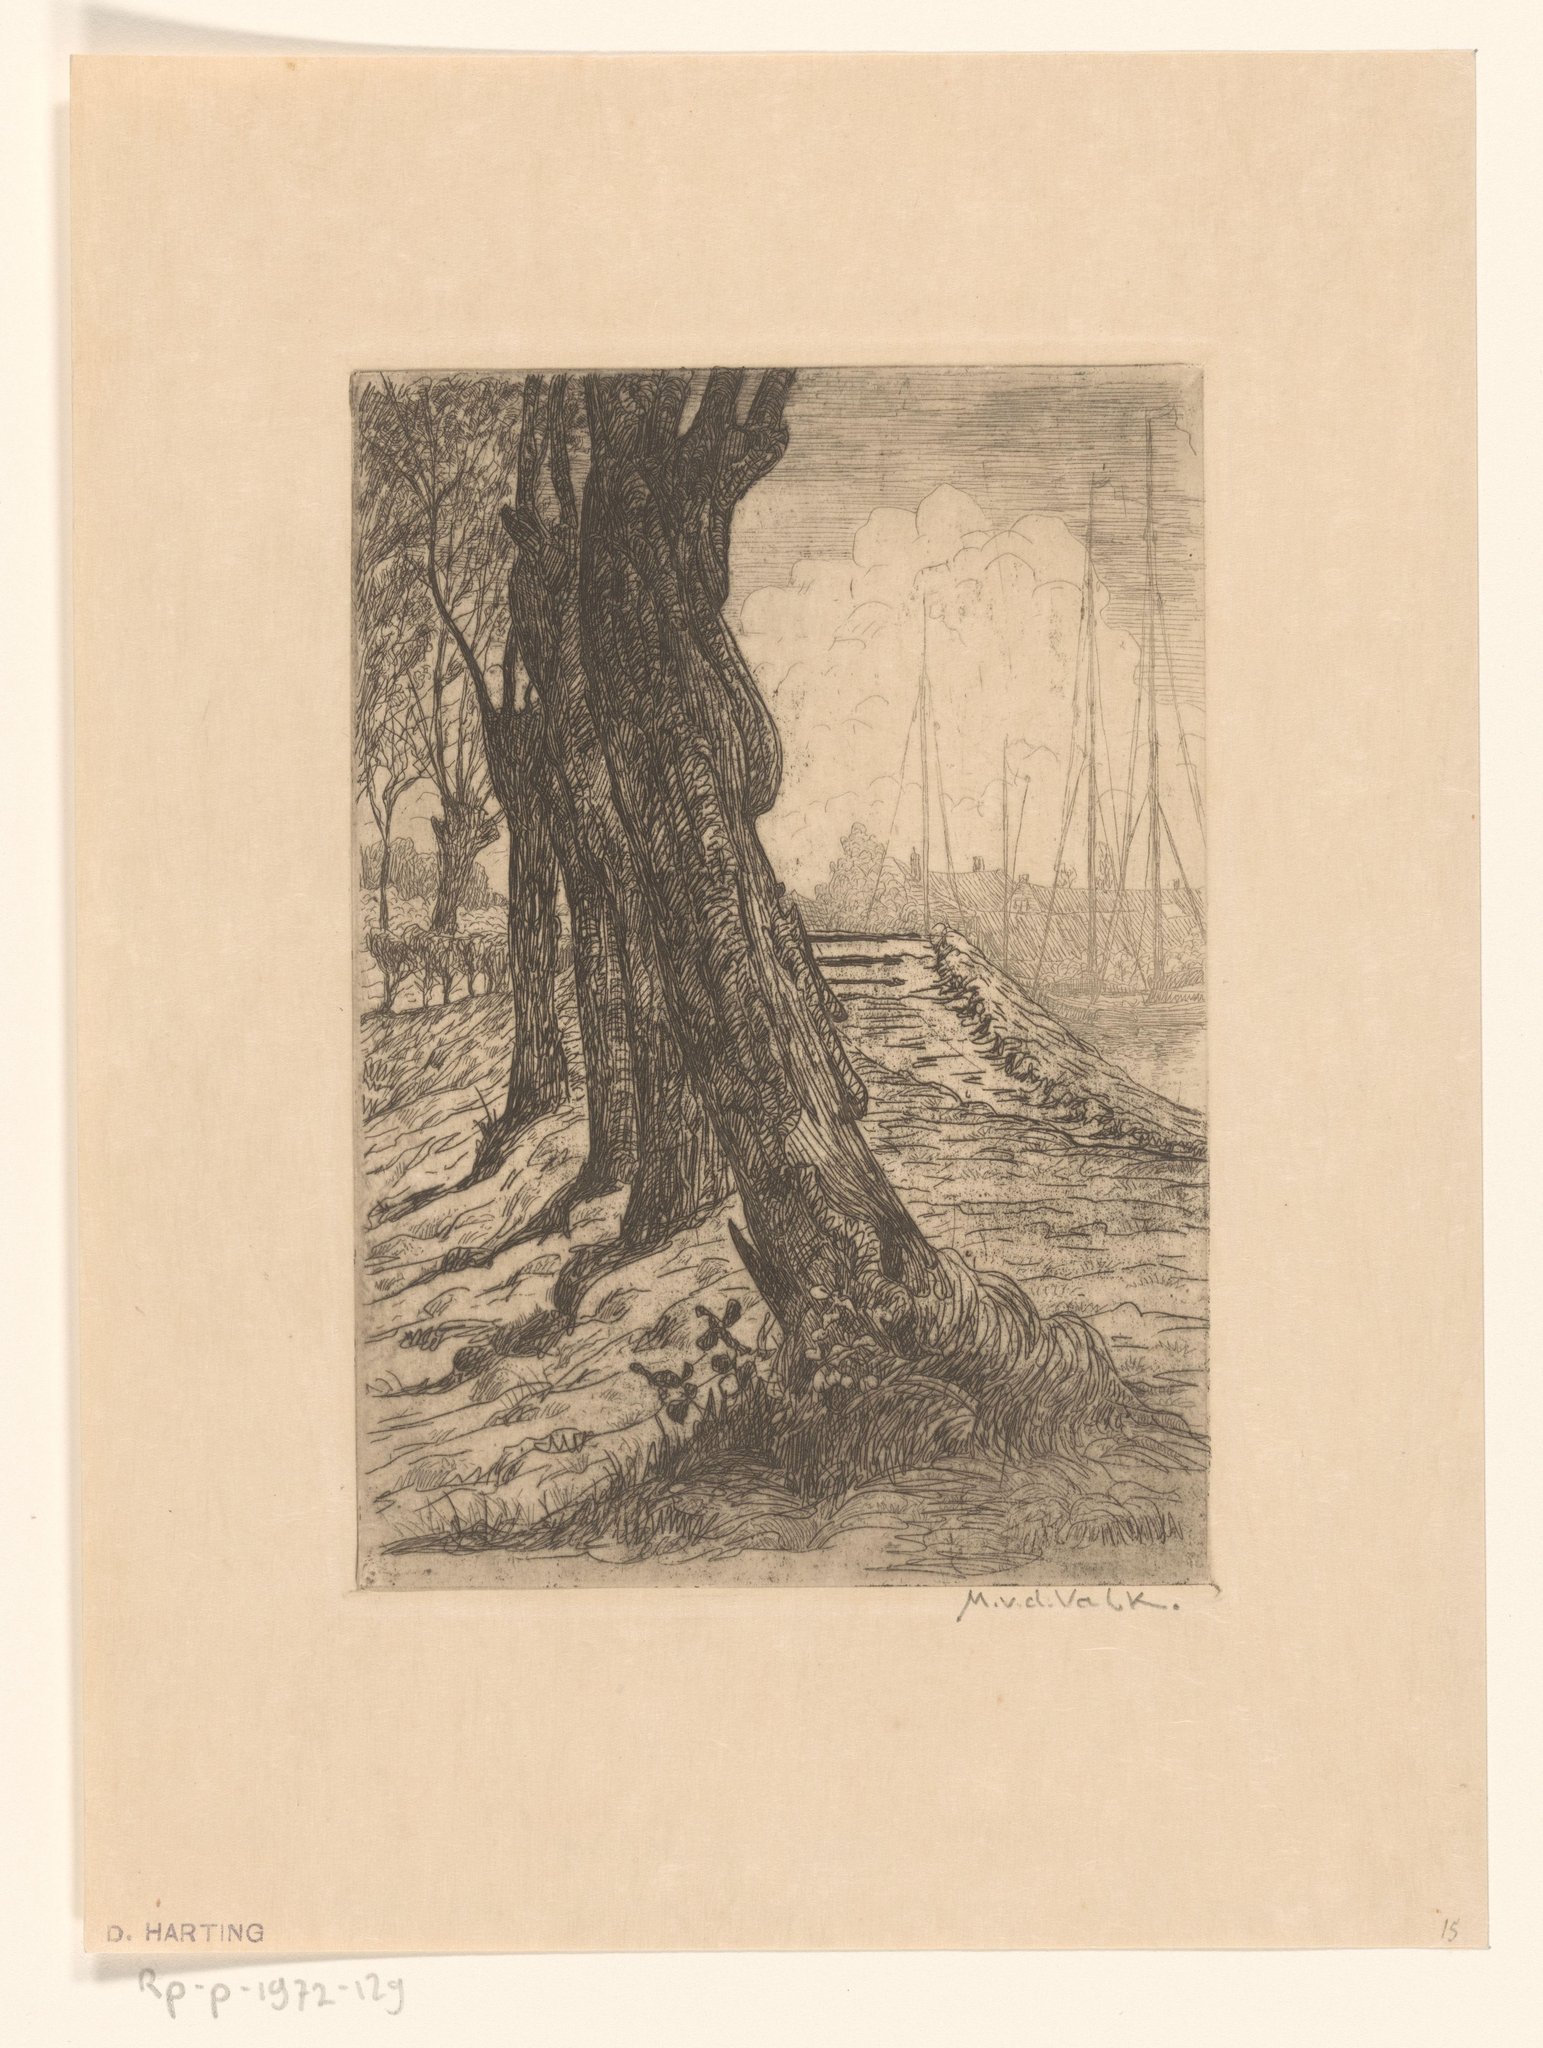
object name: print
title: Boomstammen bij een haven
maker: maurits van der valk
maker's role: draughtsman, print maker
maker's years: 1857-1935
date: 1916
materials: paper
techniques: etching, intaglio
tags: harbour, trees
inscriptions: collector's mark: Lugt 2228, collector's mark: Lugt 3623, annotation: ‘1e afdruk op nieuwe etspers. 18 mrt. 1916’, collector's mark: Lugt 2760